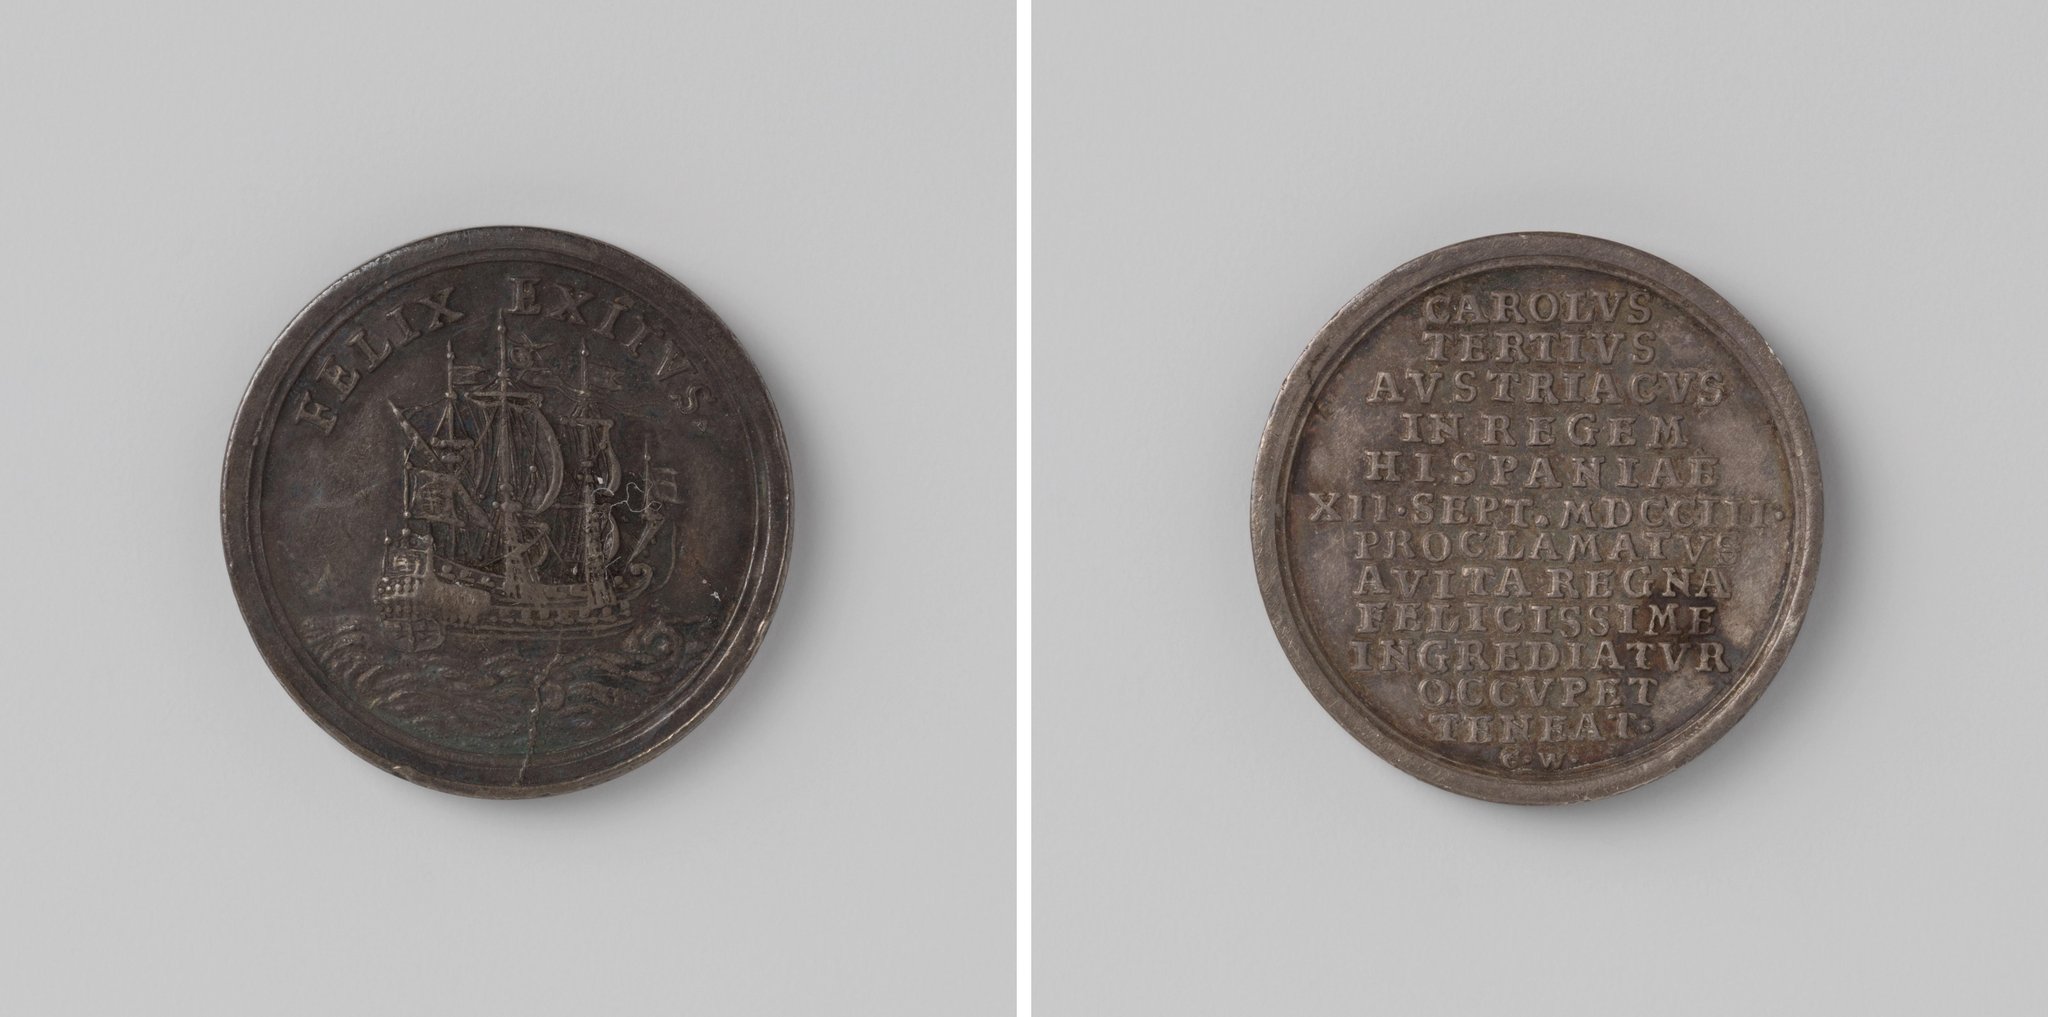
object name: strooipenning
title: Aankomst van Karel III, koning van Spanje in Portugal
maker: christian wermuth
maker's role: medailleur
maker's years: 1661-1739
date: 1704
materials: silver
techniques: striking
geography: gotha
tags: charles vi (holy roman emperor)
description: Zilveren penning. Voorzijde: opschrift. Keerzijde: schip binnen omschrift